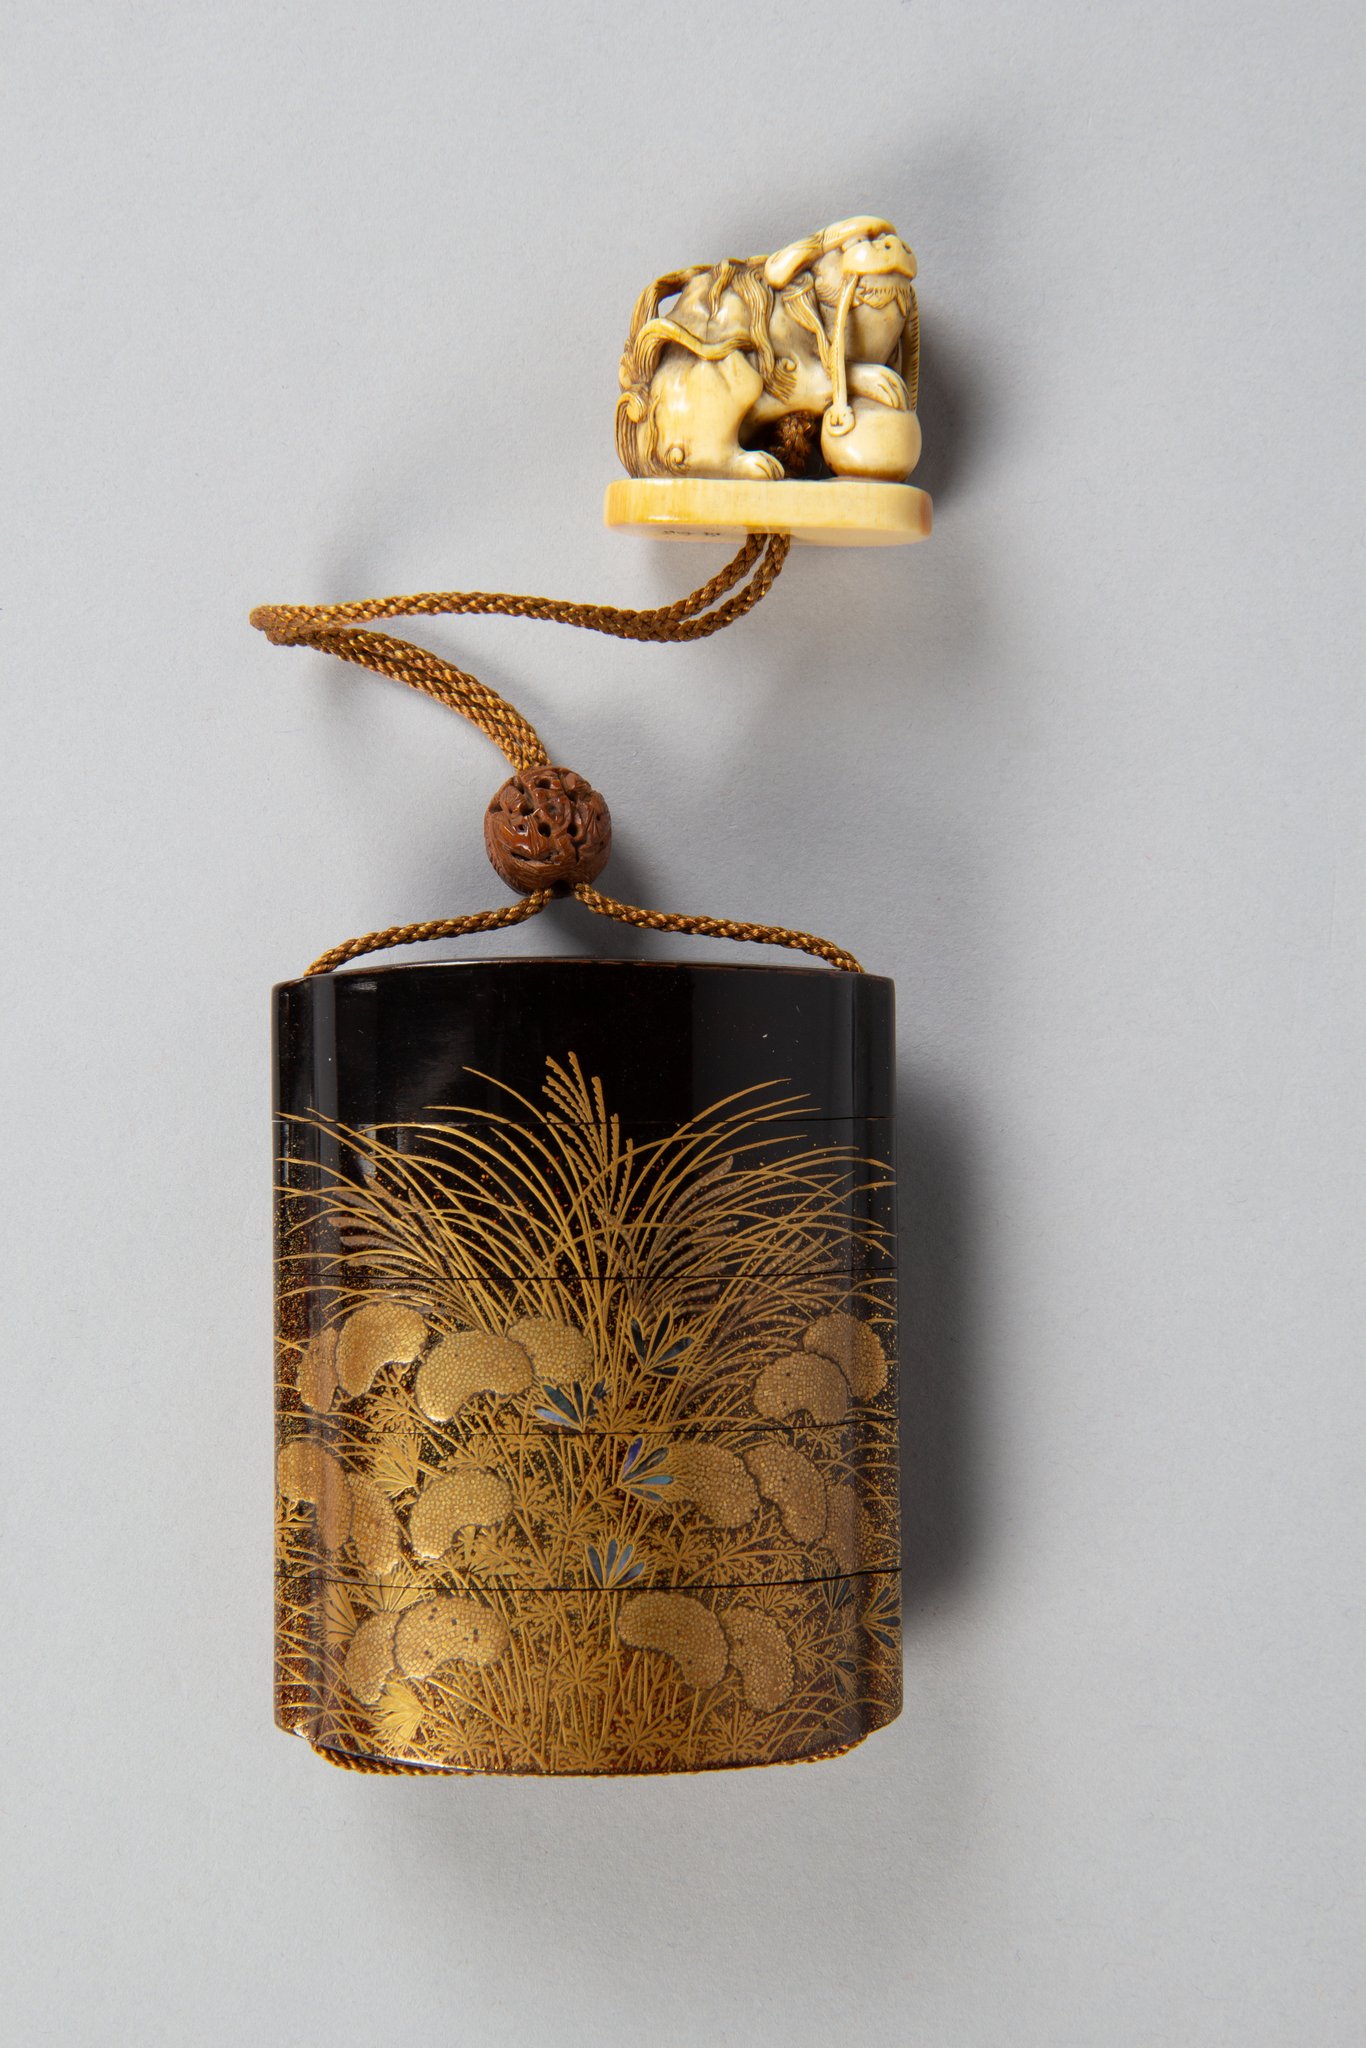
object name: inrō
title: Case (Inrō) with Design of Wild Carrot and Autumn Grasses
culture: japanese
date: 1701-1900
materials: gold, lacquer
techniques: fundame, hiramakie, inlay, roiro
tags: plants